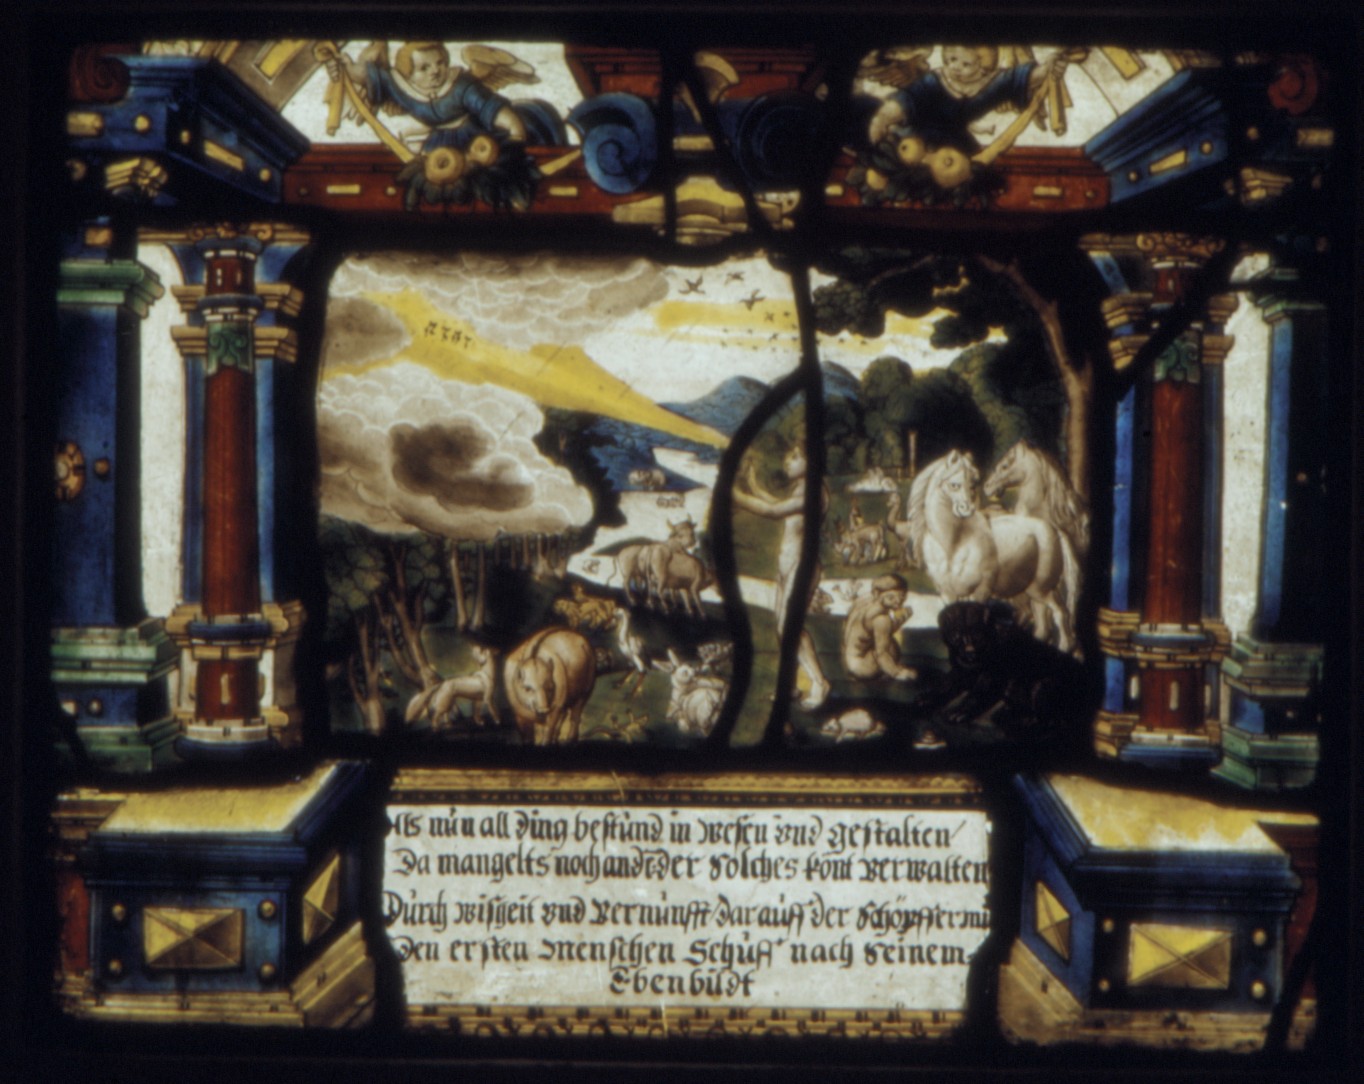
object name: panel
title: The Creation of Adam (one of a set of four)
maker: muller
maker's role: maker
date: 1634-1666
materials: glass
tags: horses,adam